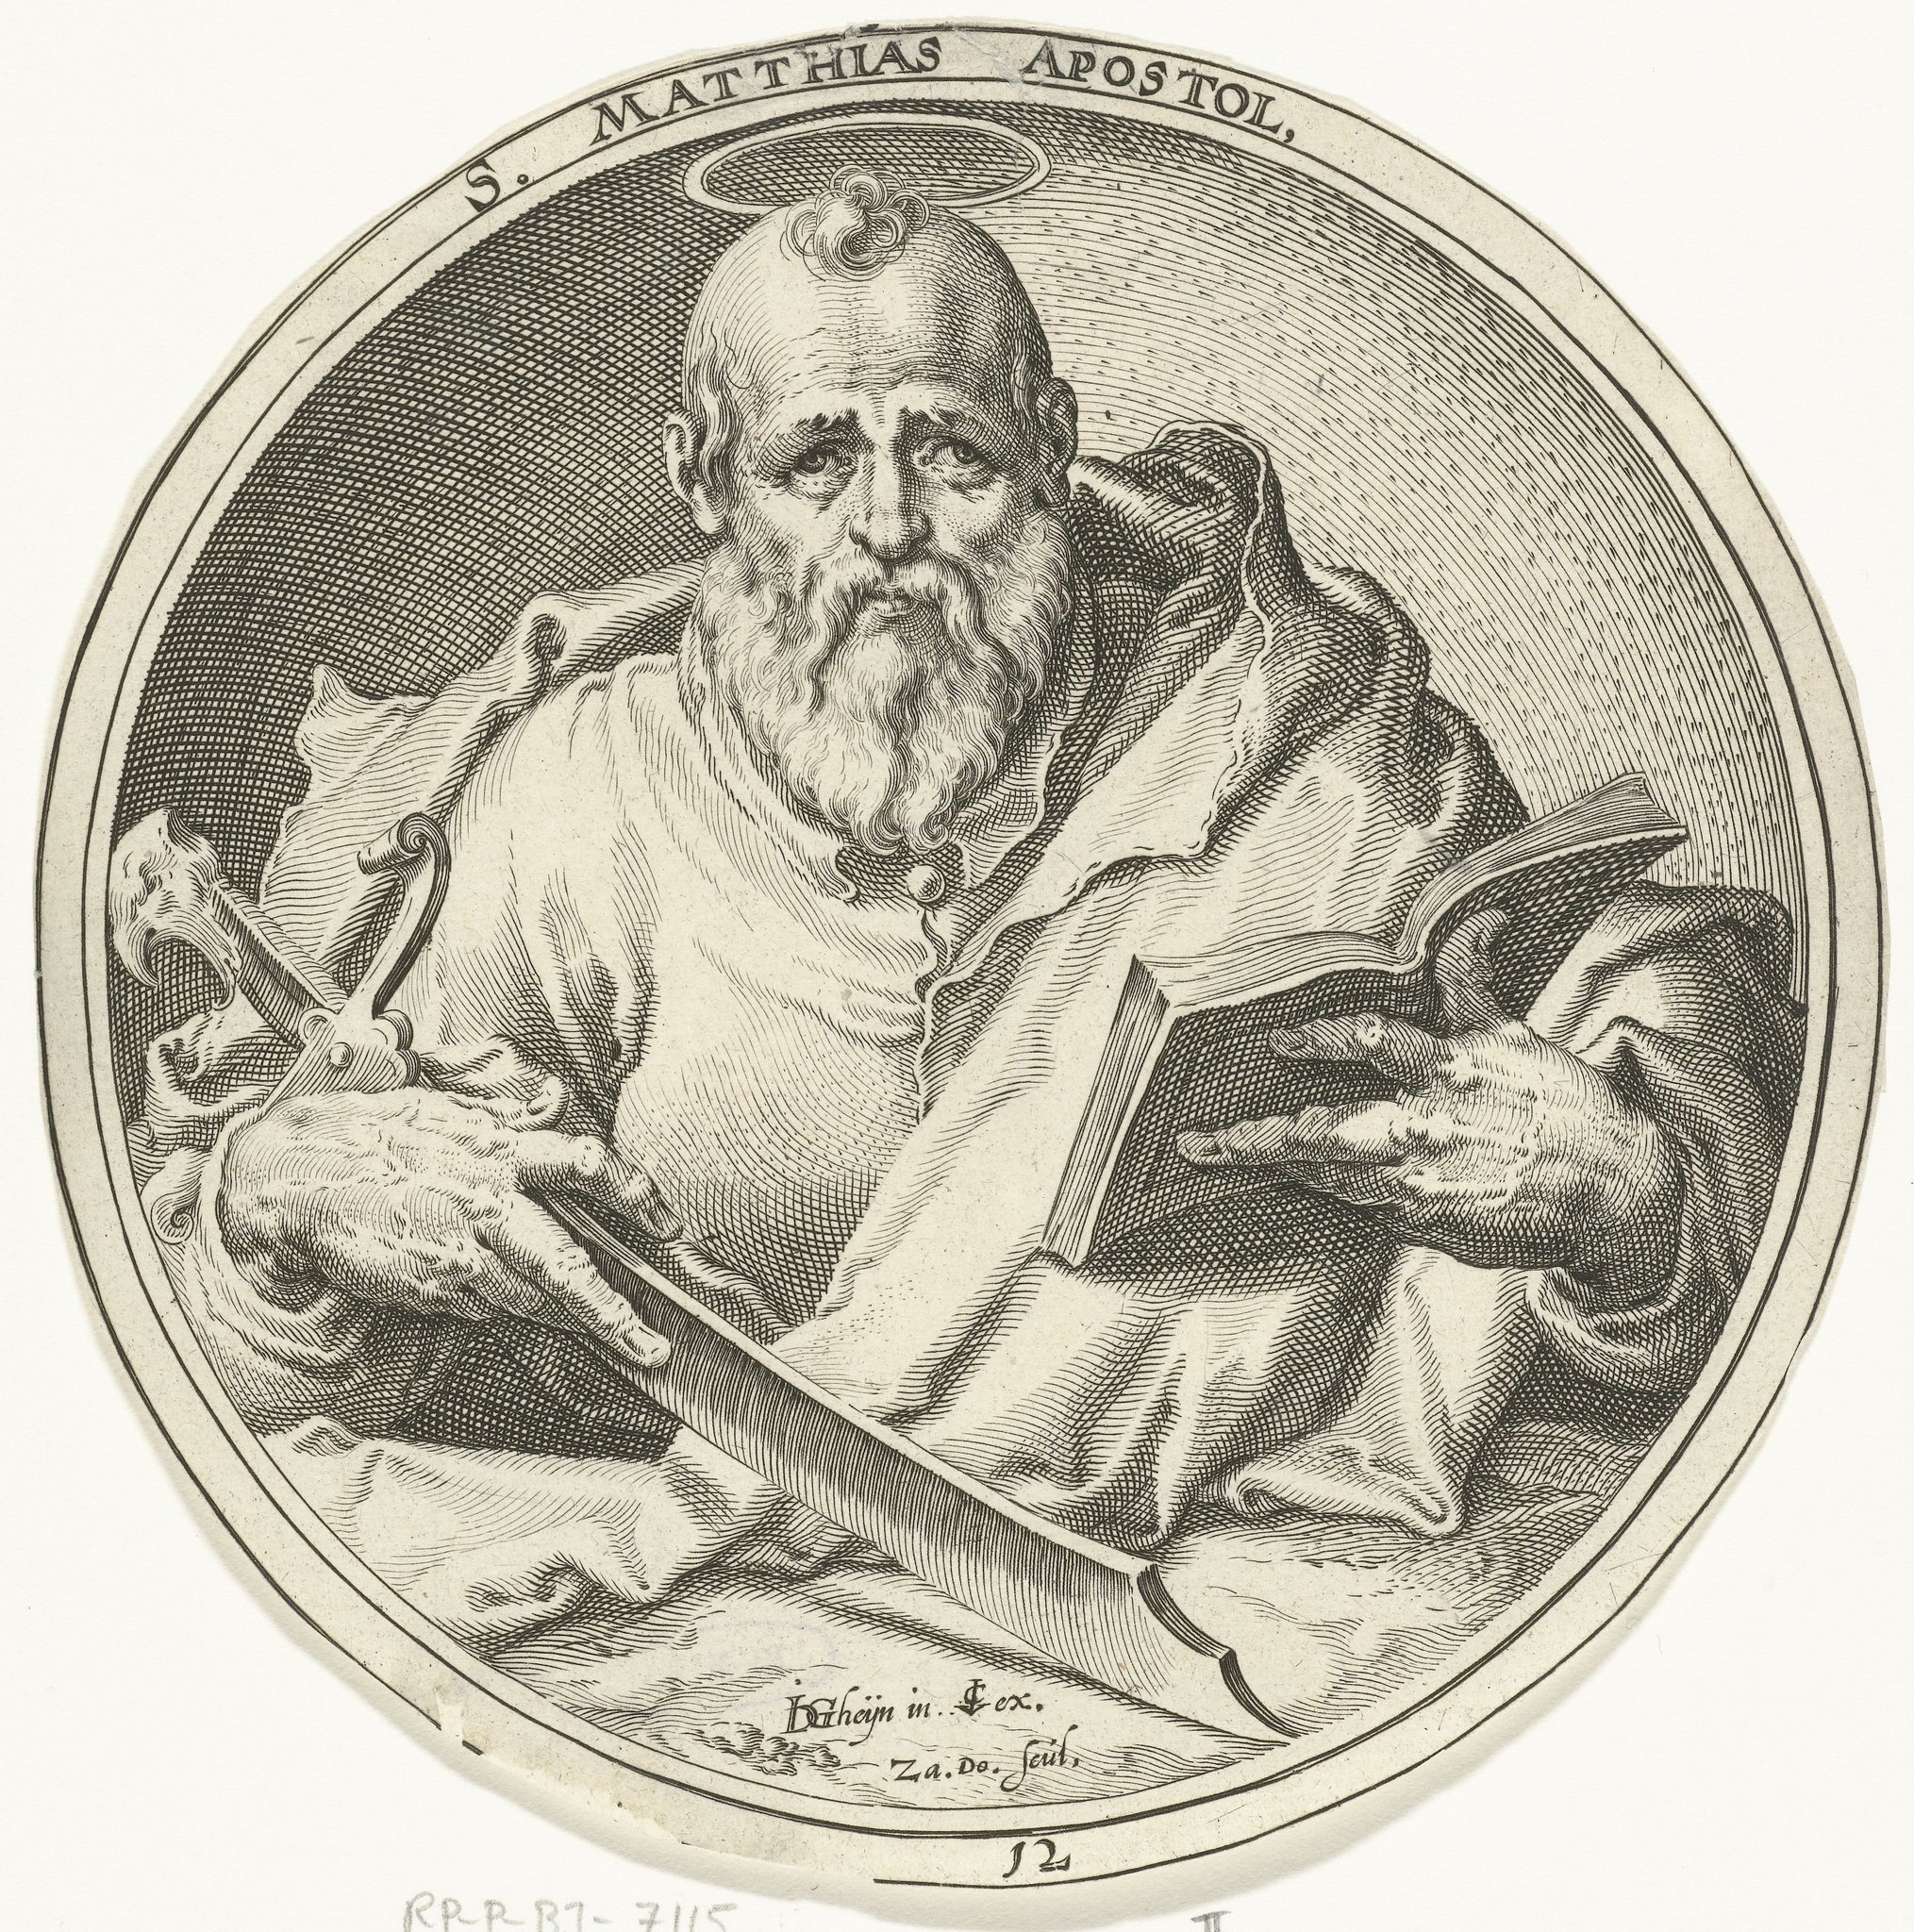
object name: print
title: H. Mathias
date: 1609-1652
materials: paper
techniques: engraving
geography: amsterdam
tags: the apostle and martyr matthias; possible attributes: axe, book, cross, halberd, scroll, sword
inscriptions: collector's mark: Lugt 2228